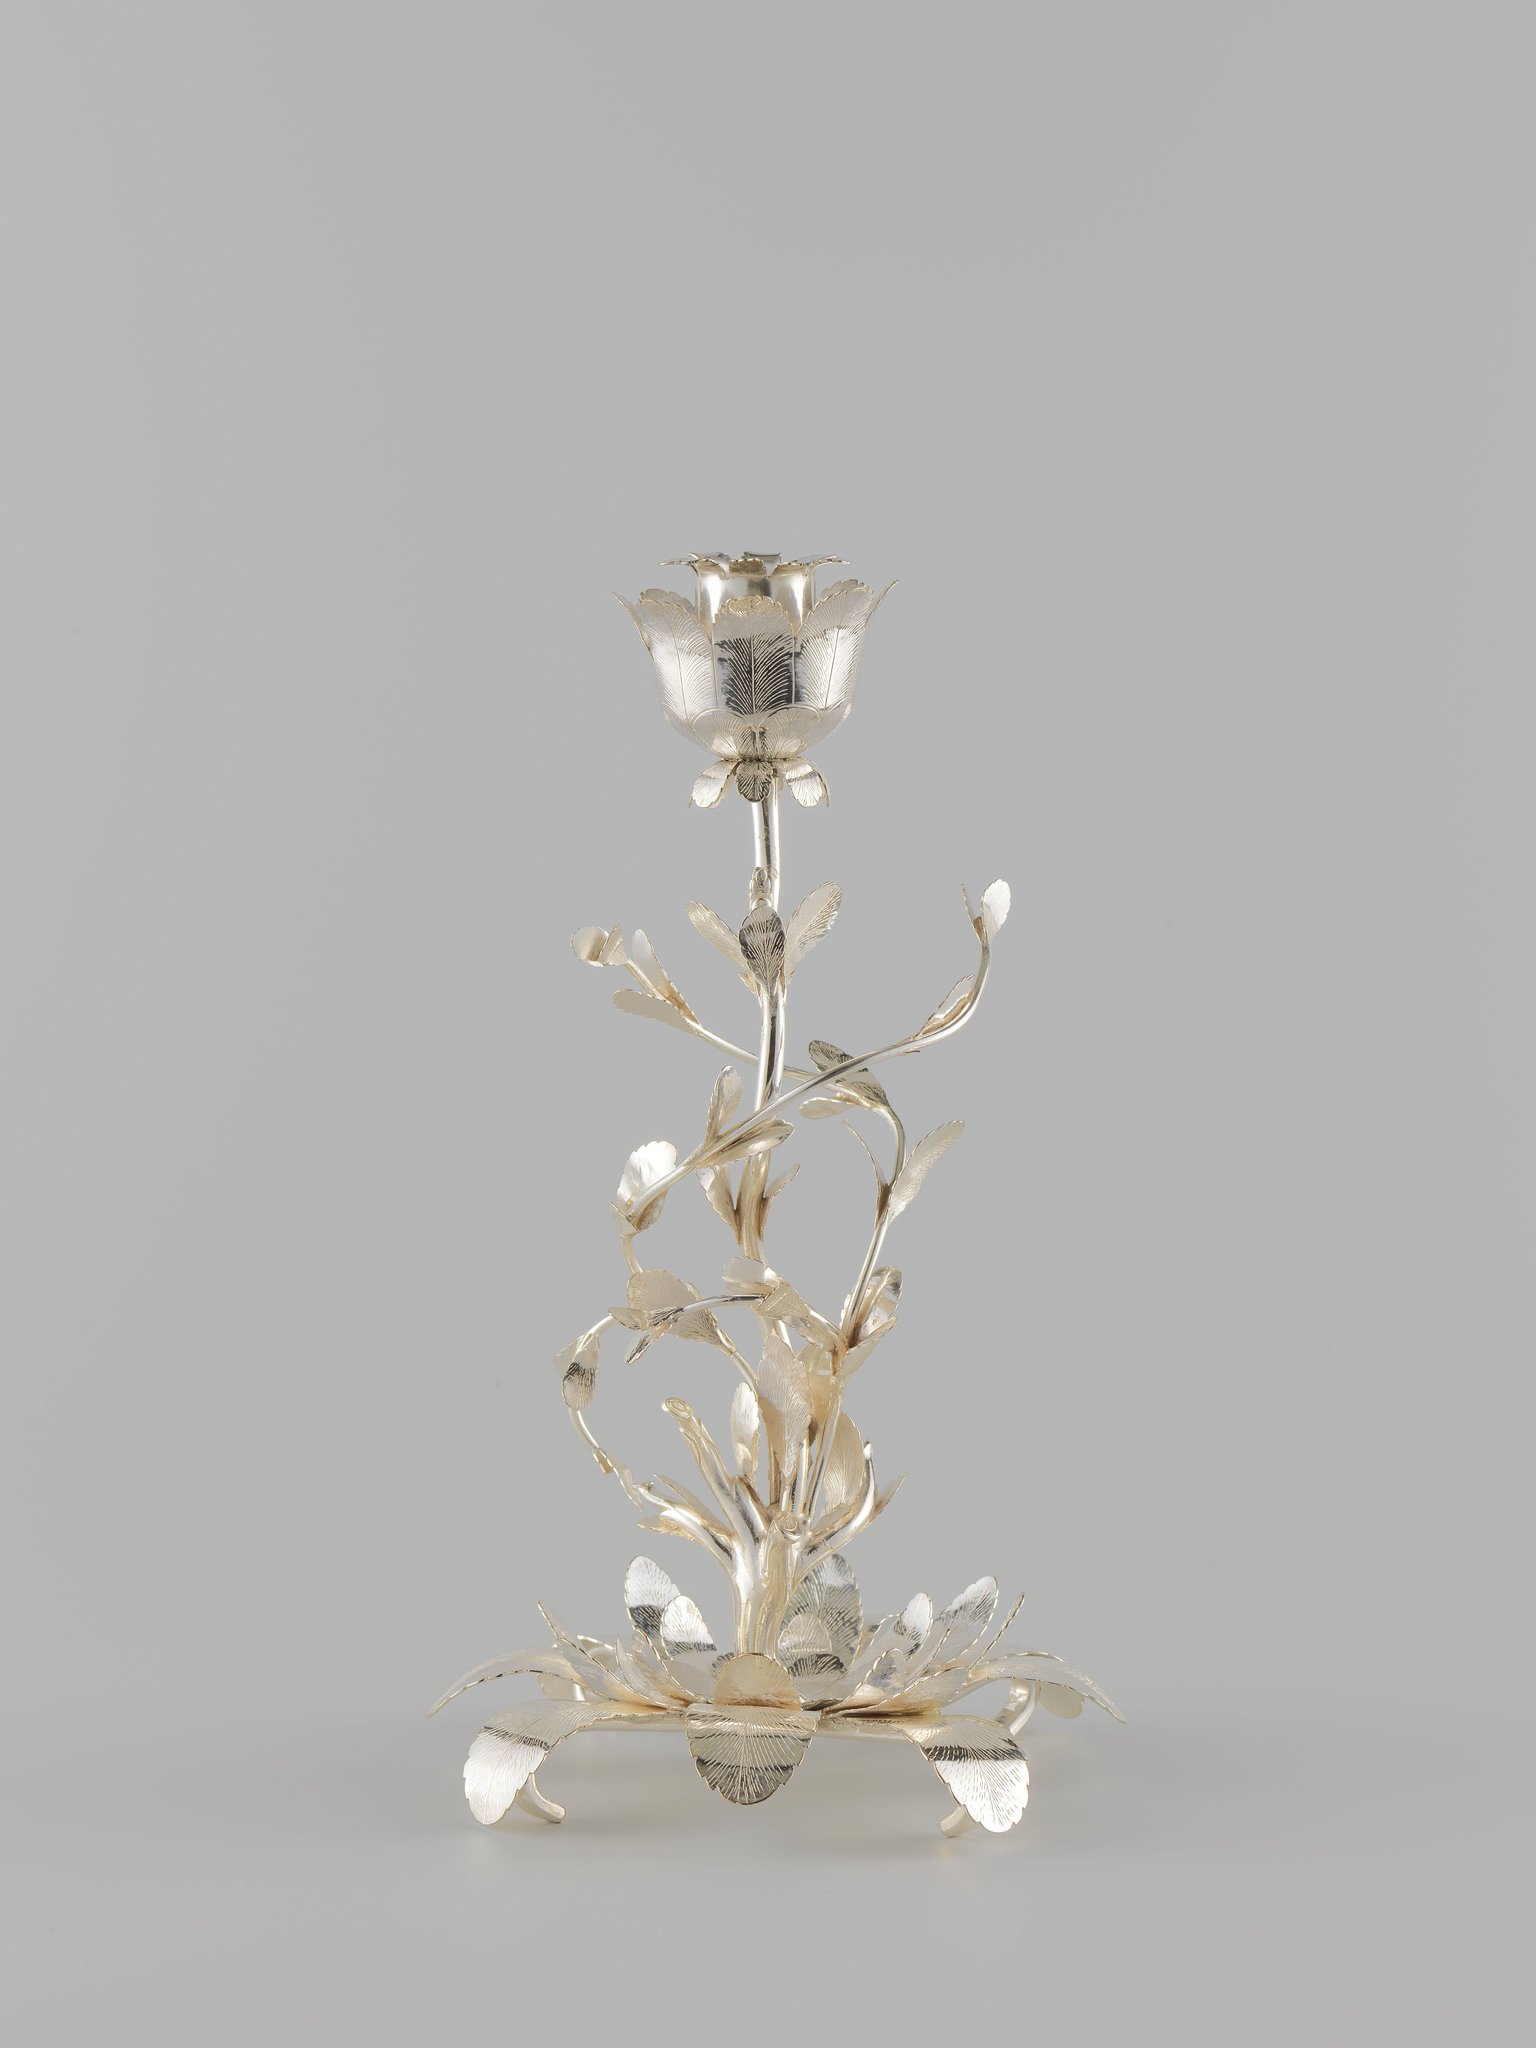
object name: candlestick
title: Kandelaar van zilver met stam in de vorm van een kronkelende boomstam met drie slingerende takken met ovaal blad en kaarsenhouder in bloemkroon.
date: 1784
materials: silver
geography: dordrecht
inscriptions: mark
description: Kandelaar van zilver. Uit een bladrozet rijst een kronkelende boomstam, die zich verdeelt in drie slingerende takken met ovale bladeren. De kaarsenhouder is gevat in een bloemkroon.